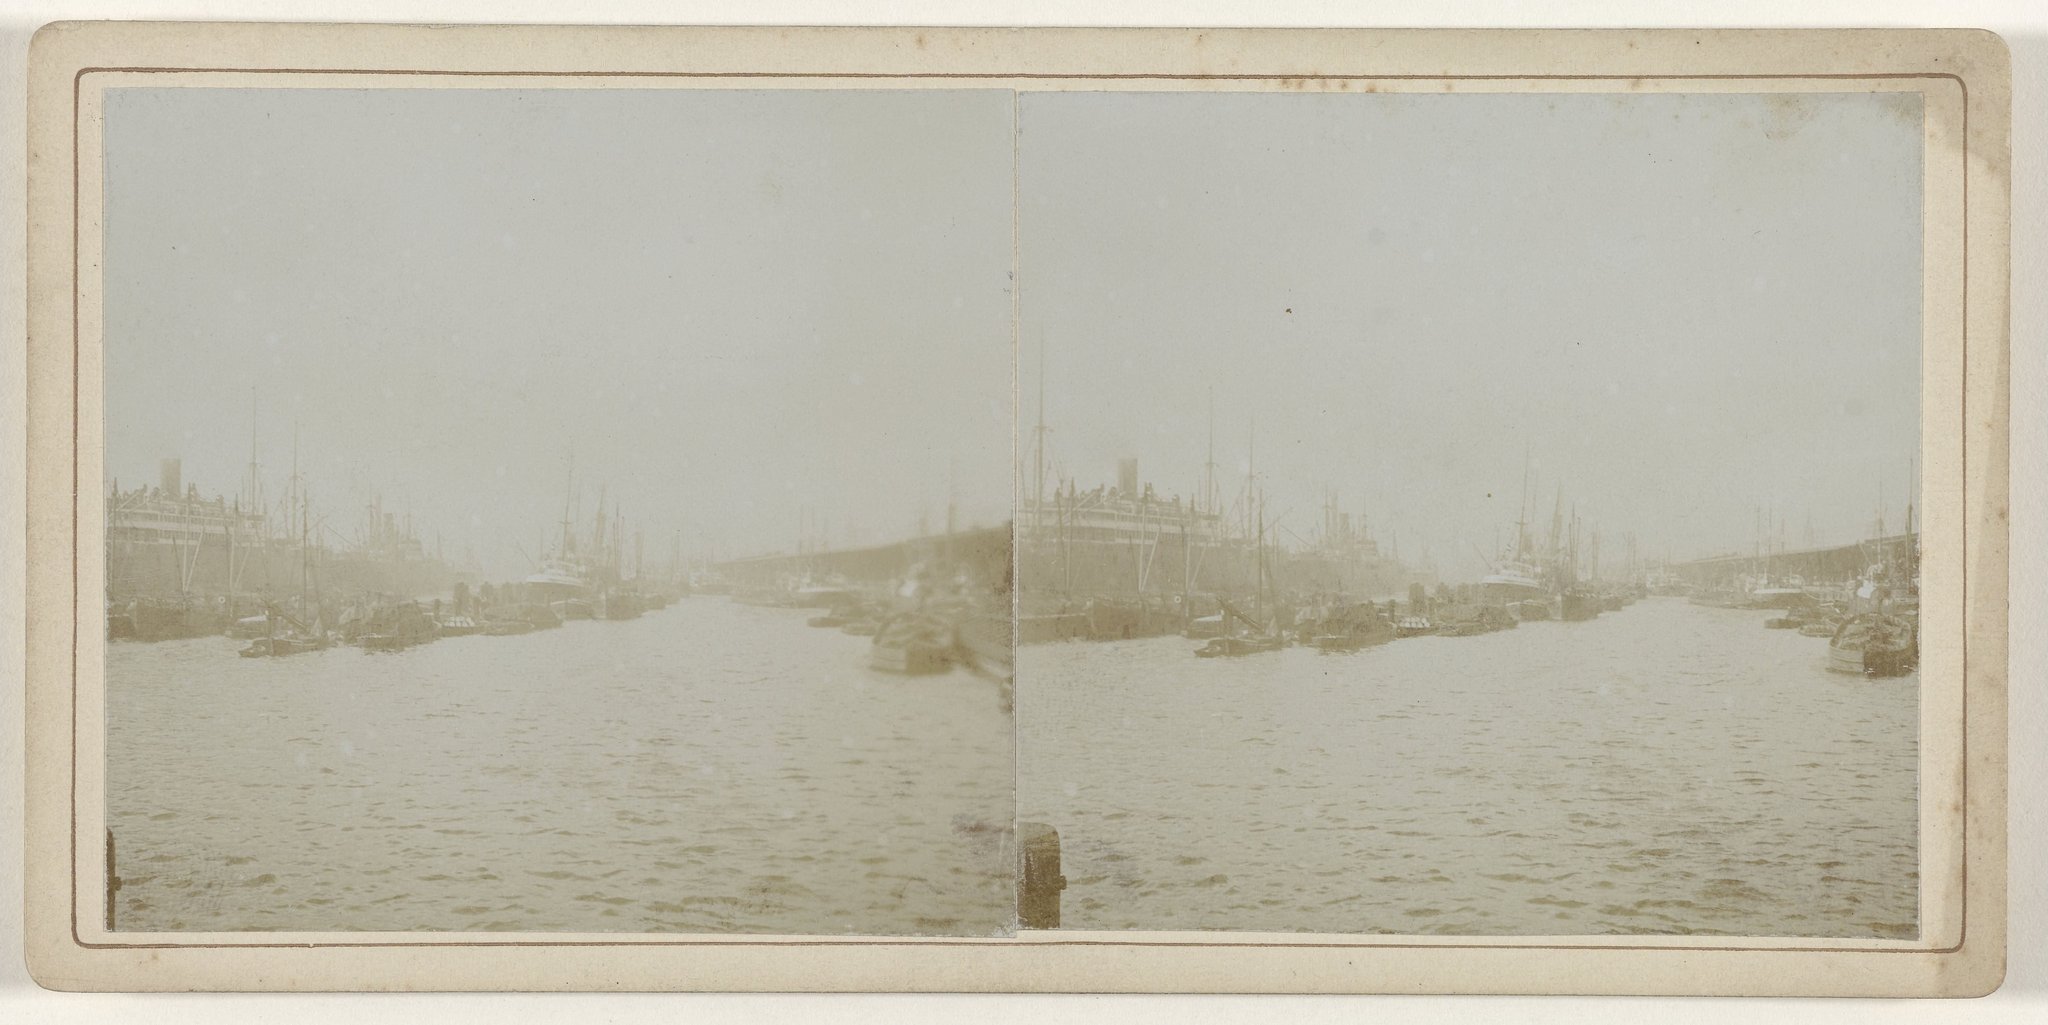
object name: stereograph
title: Haven met aangemeerde zeil en stoomschepen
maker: geldolph adriaan kessler (dolph)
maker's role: fotograaf, industrieel, voetballer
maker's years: 1884-1945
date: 1903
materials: paper, photographic support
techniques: collodion silver print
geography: hamburg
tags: hamburg